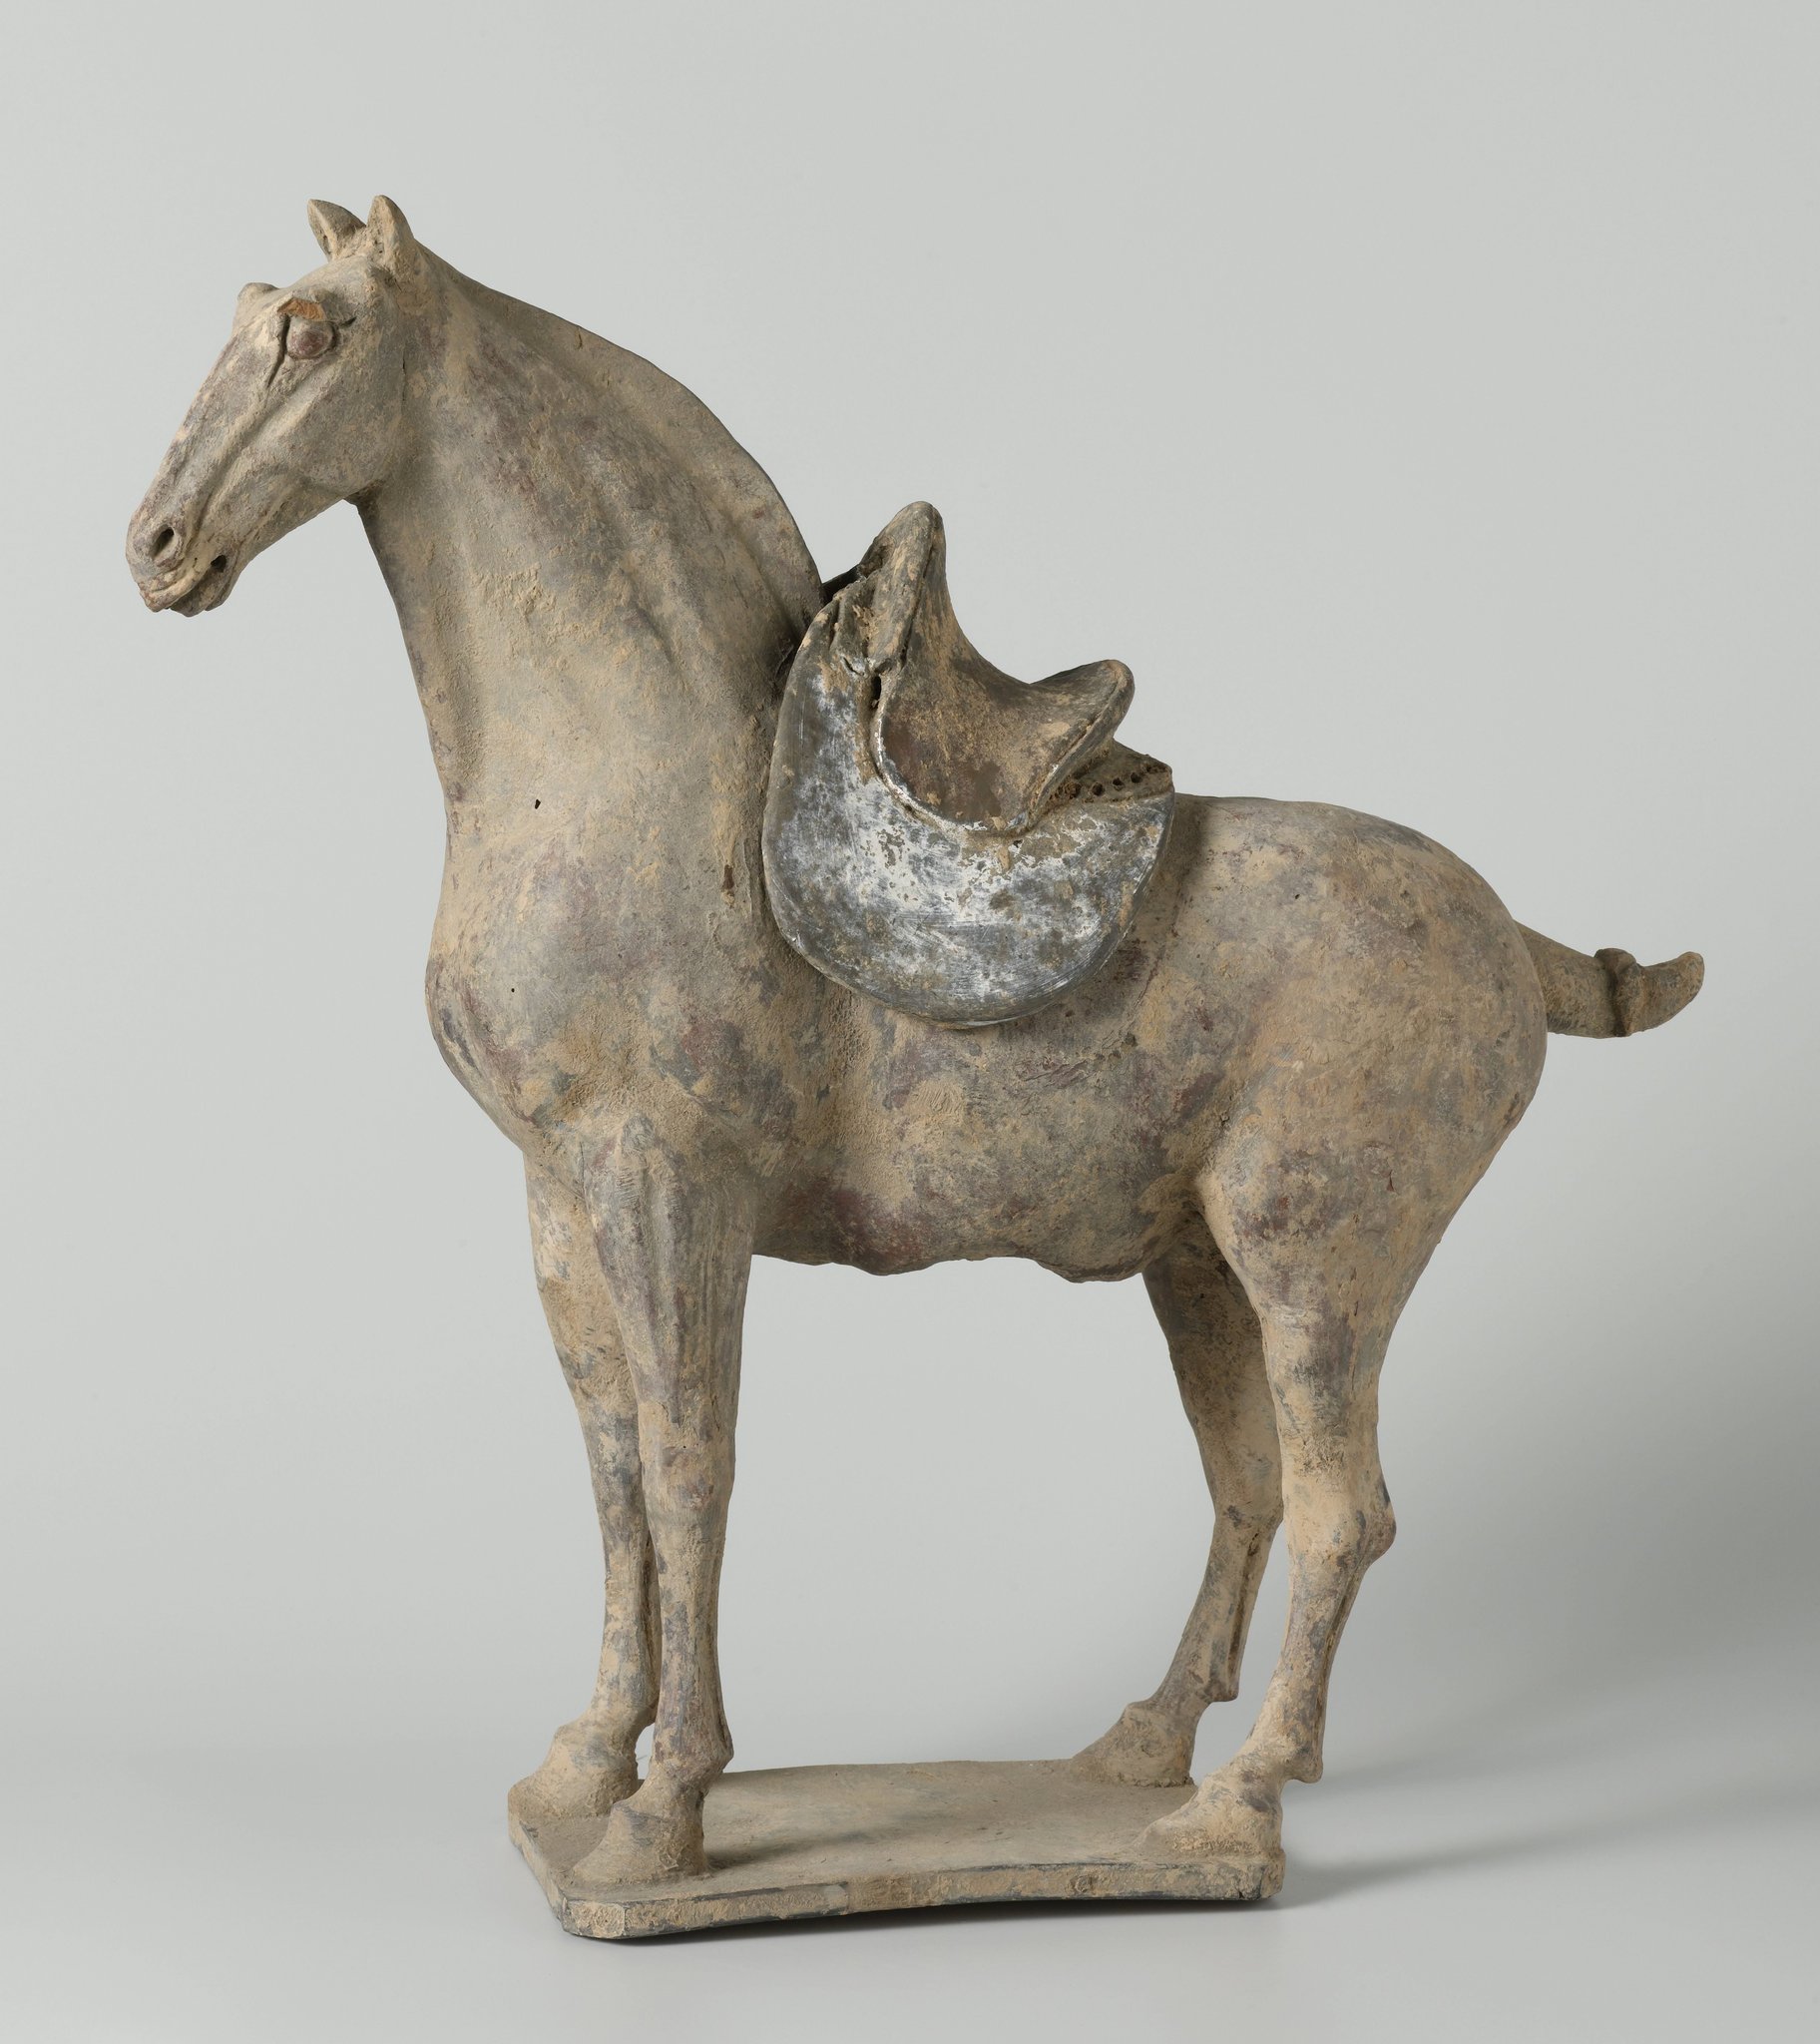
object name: figure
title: Tomb Figures of Horses and Camels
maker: Anonymous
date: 650-750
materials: dye, earthenware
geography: china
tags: saddle, horse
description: Beeld in de vorm van een gezadeld paard uit een serie van zes graffiguren. Sporen van polychromie. Tang.